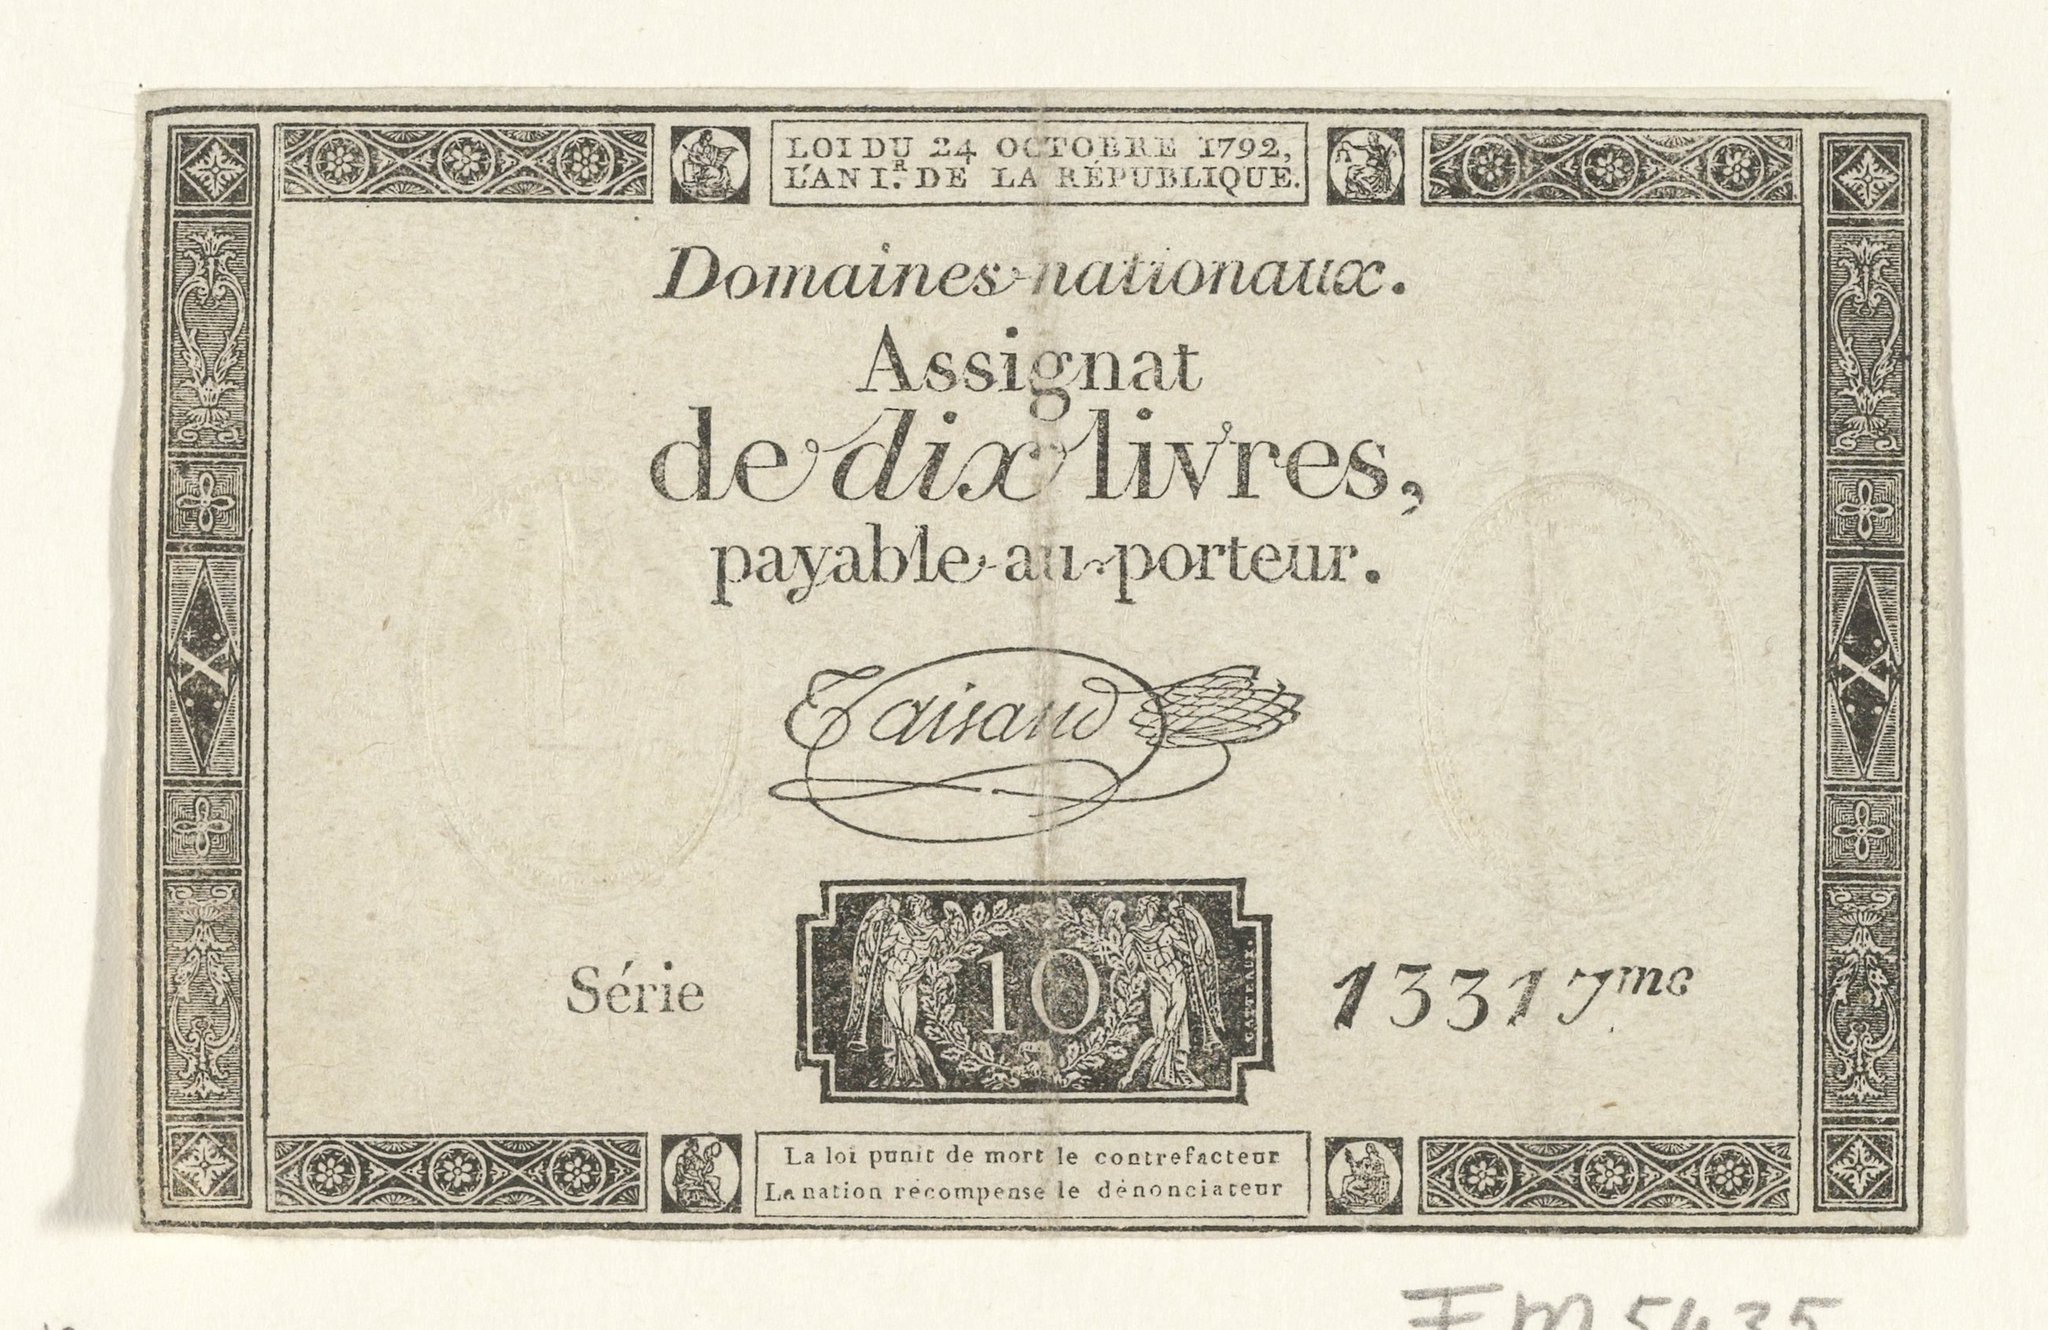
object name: assignat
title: Assignaat van 10 livres, 1792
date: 1792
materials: paper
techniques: blind stamped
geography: france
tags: bank-note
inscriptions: collector's mark: Lugt 2228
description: Assignaat van 10 livres. In omloop gebracht door de Domaines nationaux, serie 13317, volgens de wet van 24 oktober 1792.